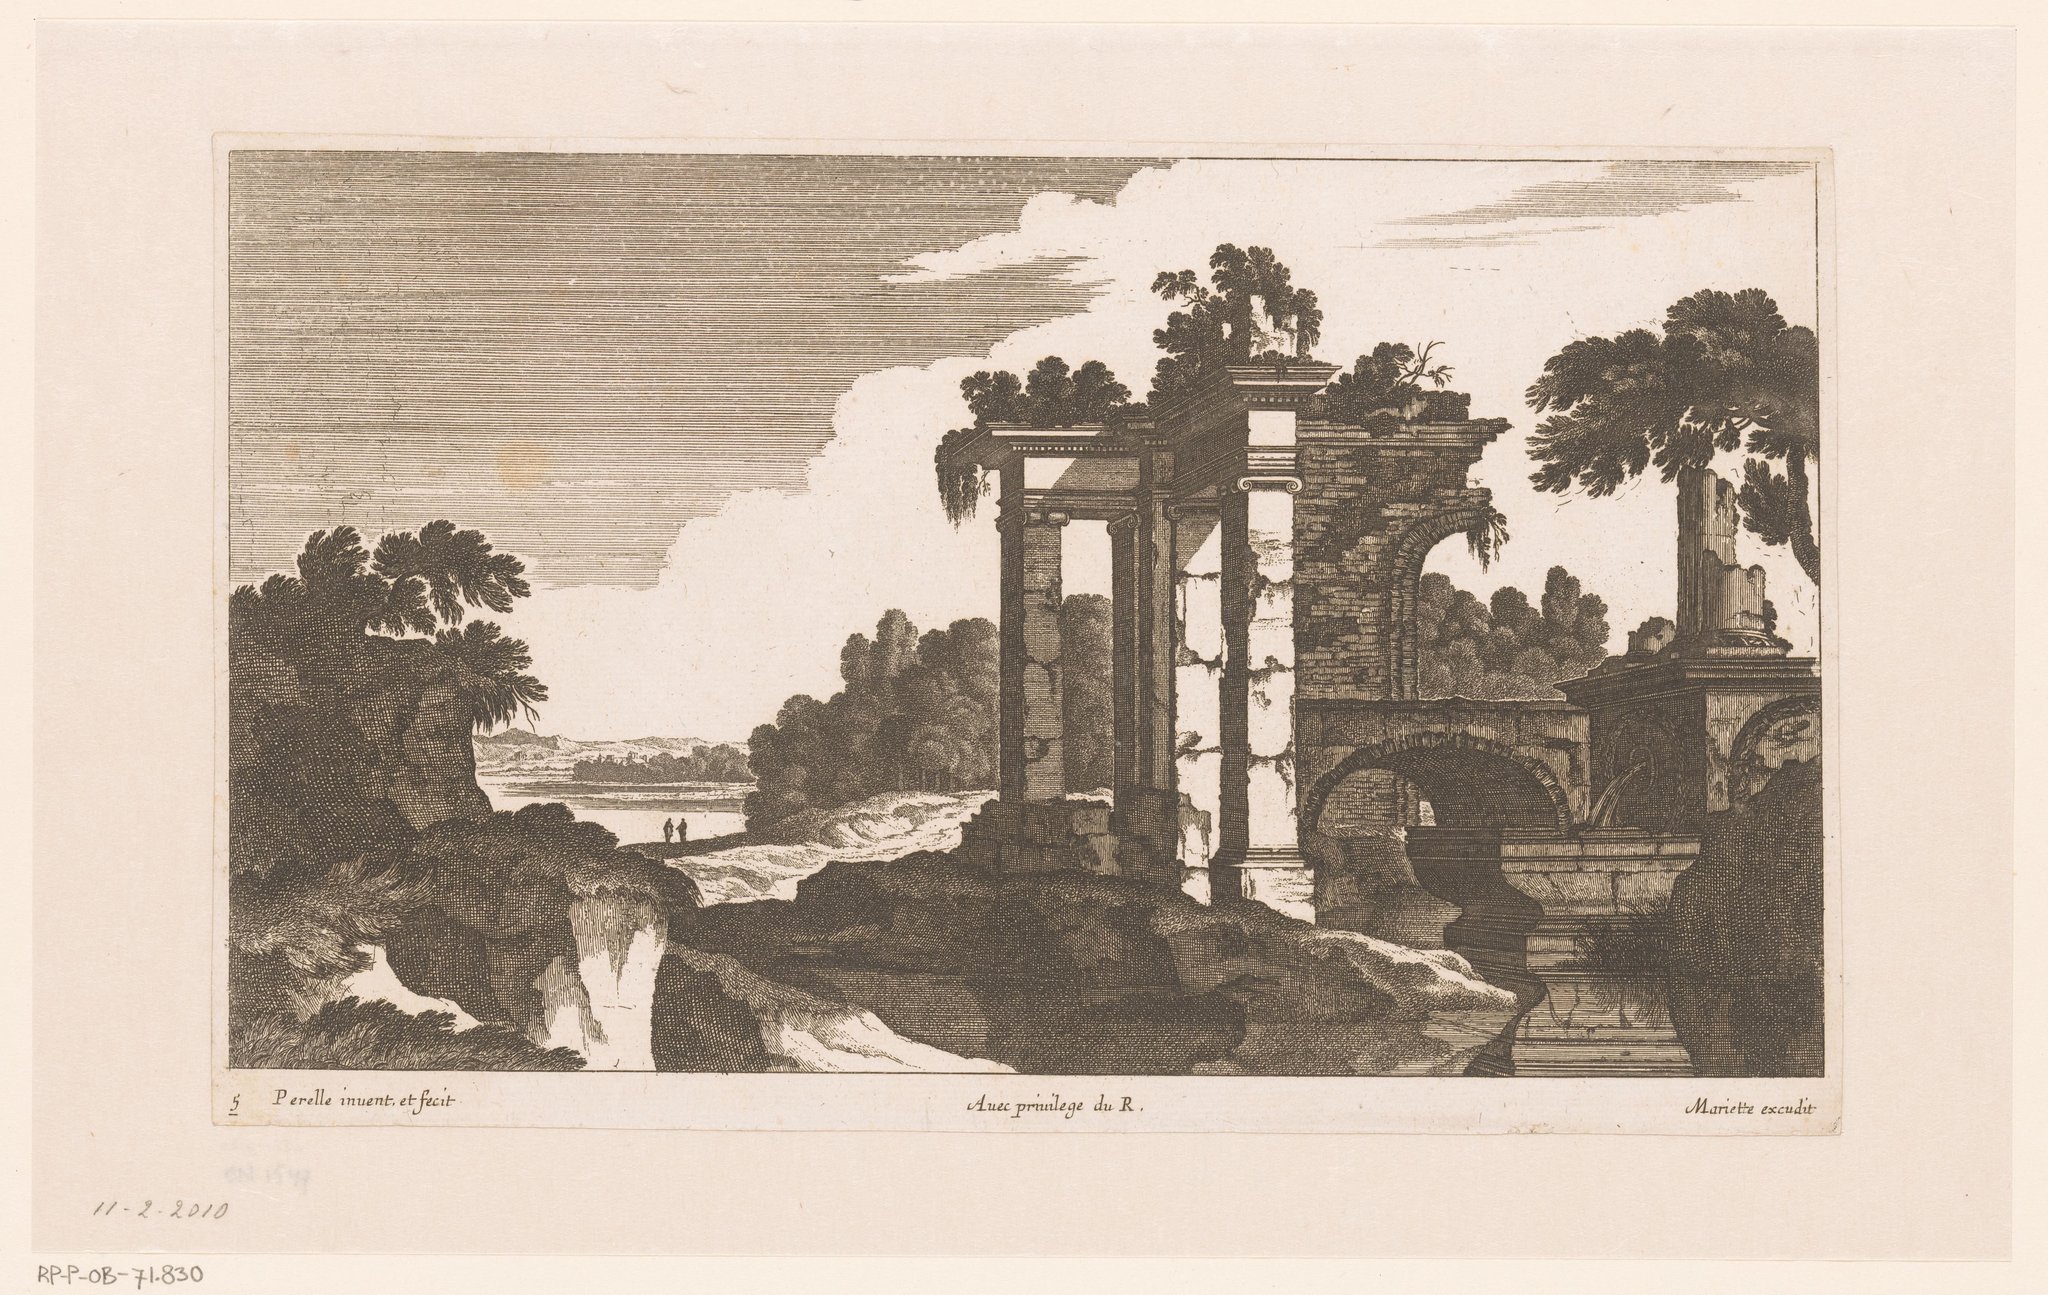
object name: print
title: Landschap met antieke ruïnes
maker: mariette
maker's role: publisher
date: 1613-1695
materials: paper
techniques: engraving, etching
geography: france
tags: landscape with ruins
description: Prenten met het signatuur 'Perelle' kunnen zowel door vader Gabriel als door zonen Nicolas en Adam gemaakt zijn.